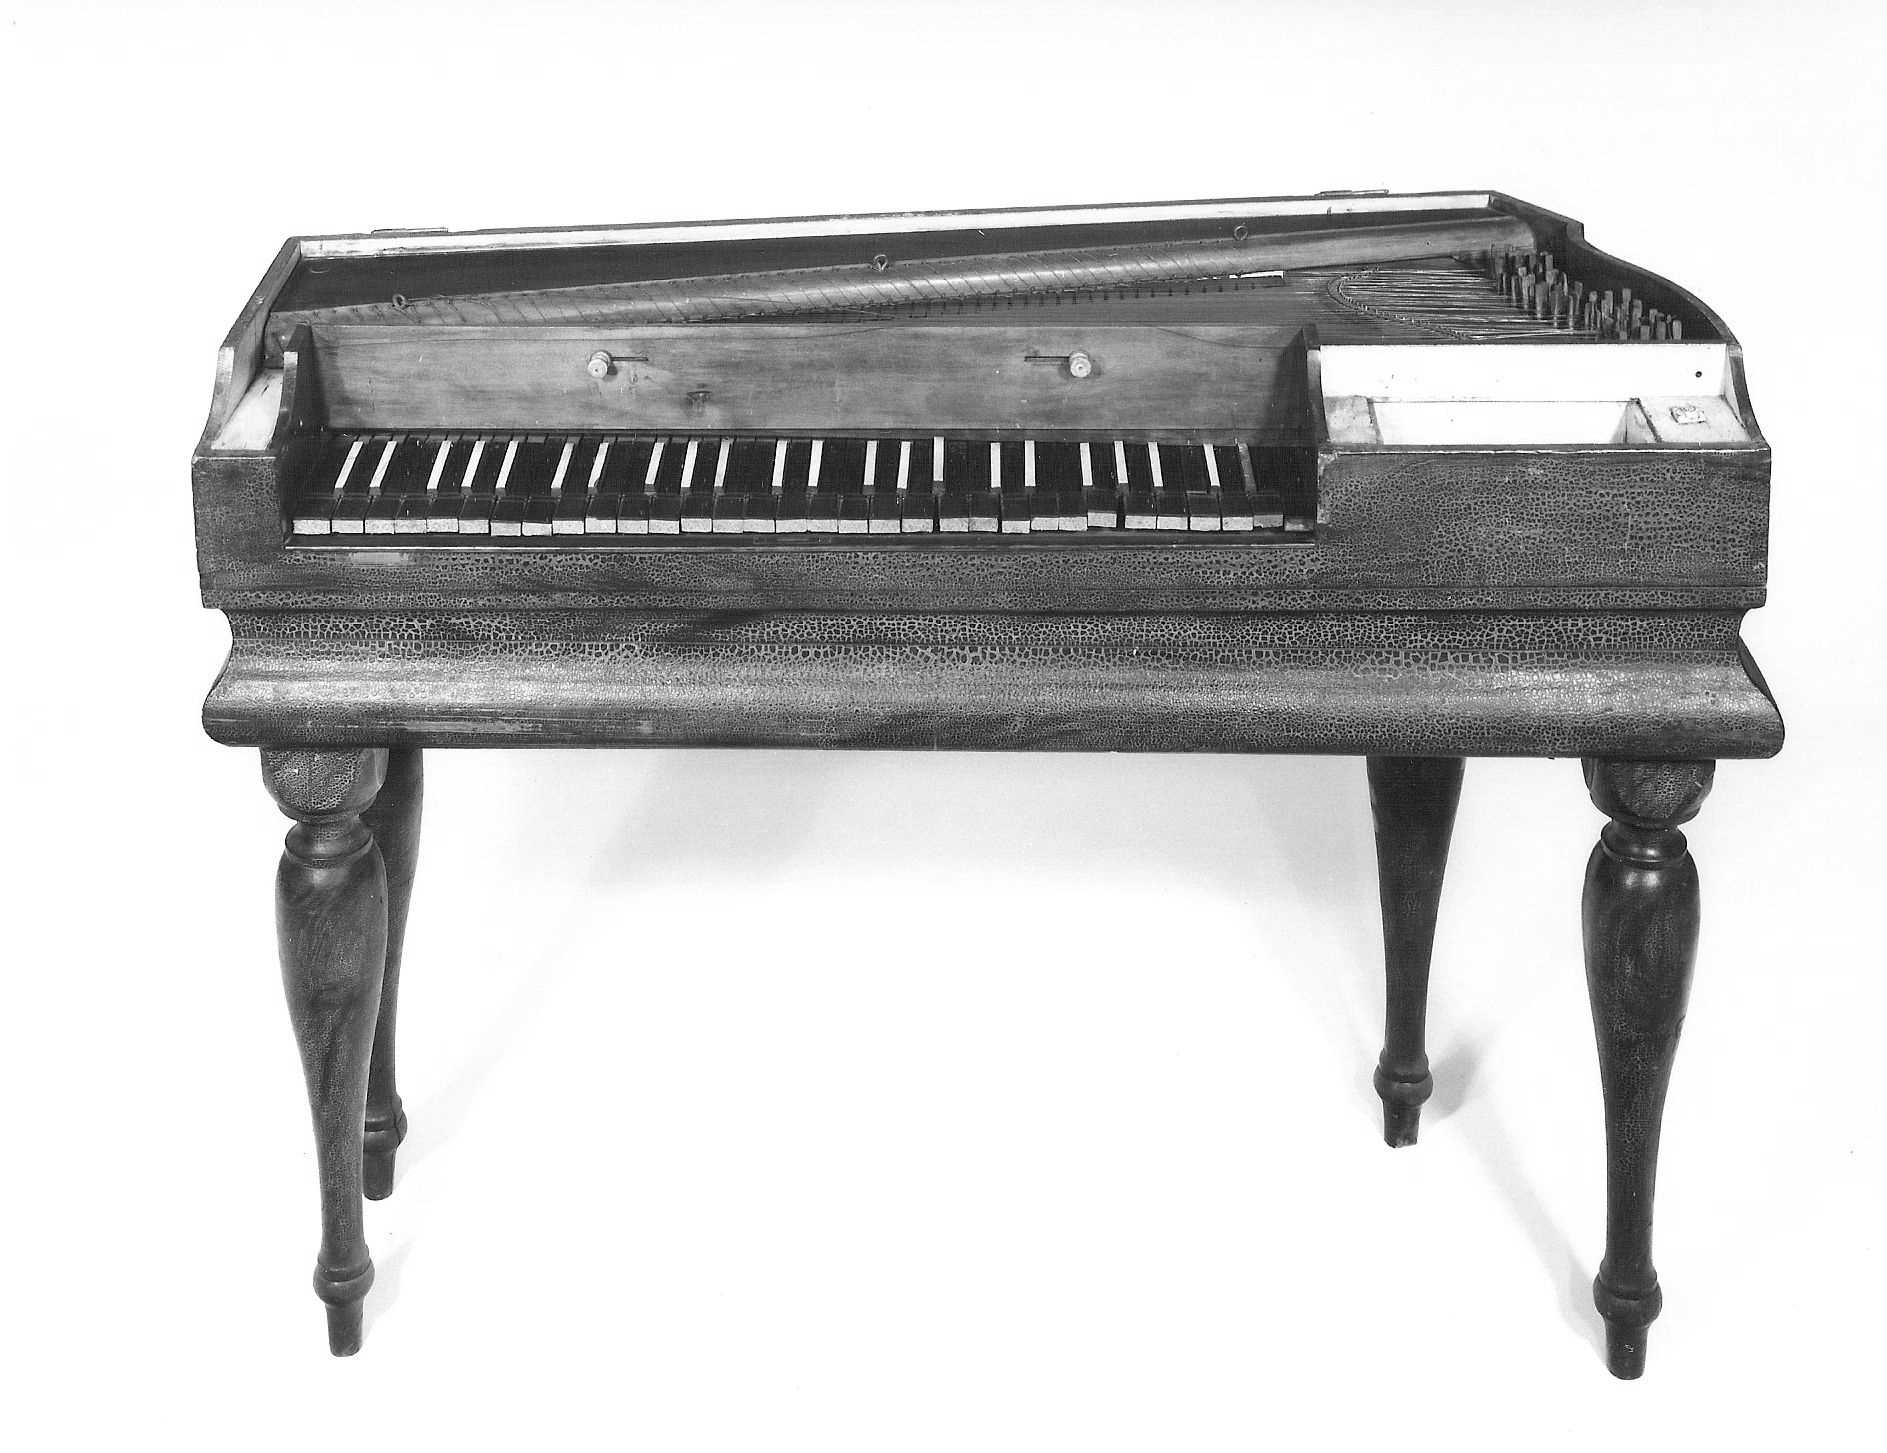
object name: square piano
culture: german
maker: johann matthäus schmahl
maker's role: maker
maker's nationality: german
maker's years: 1734-1793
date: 1790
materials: wood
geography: germany